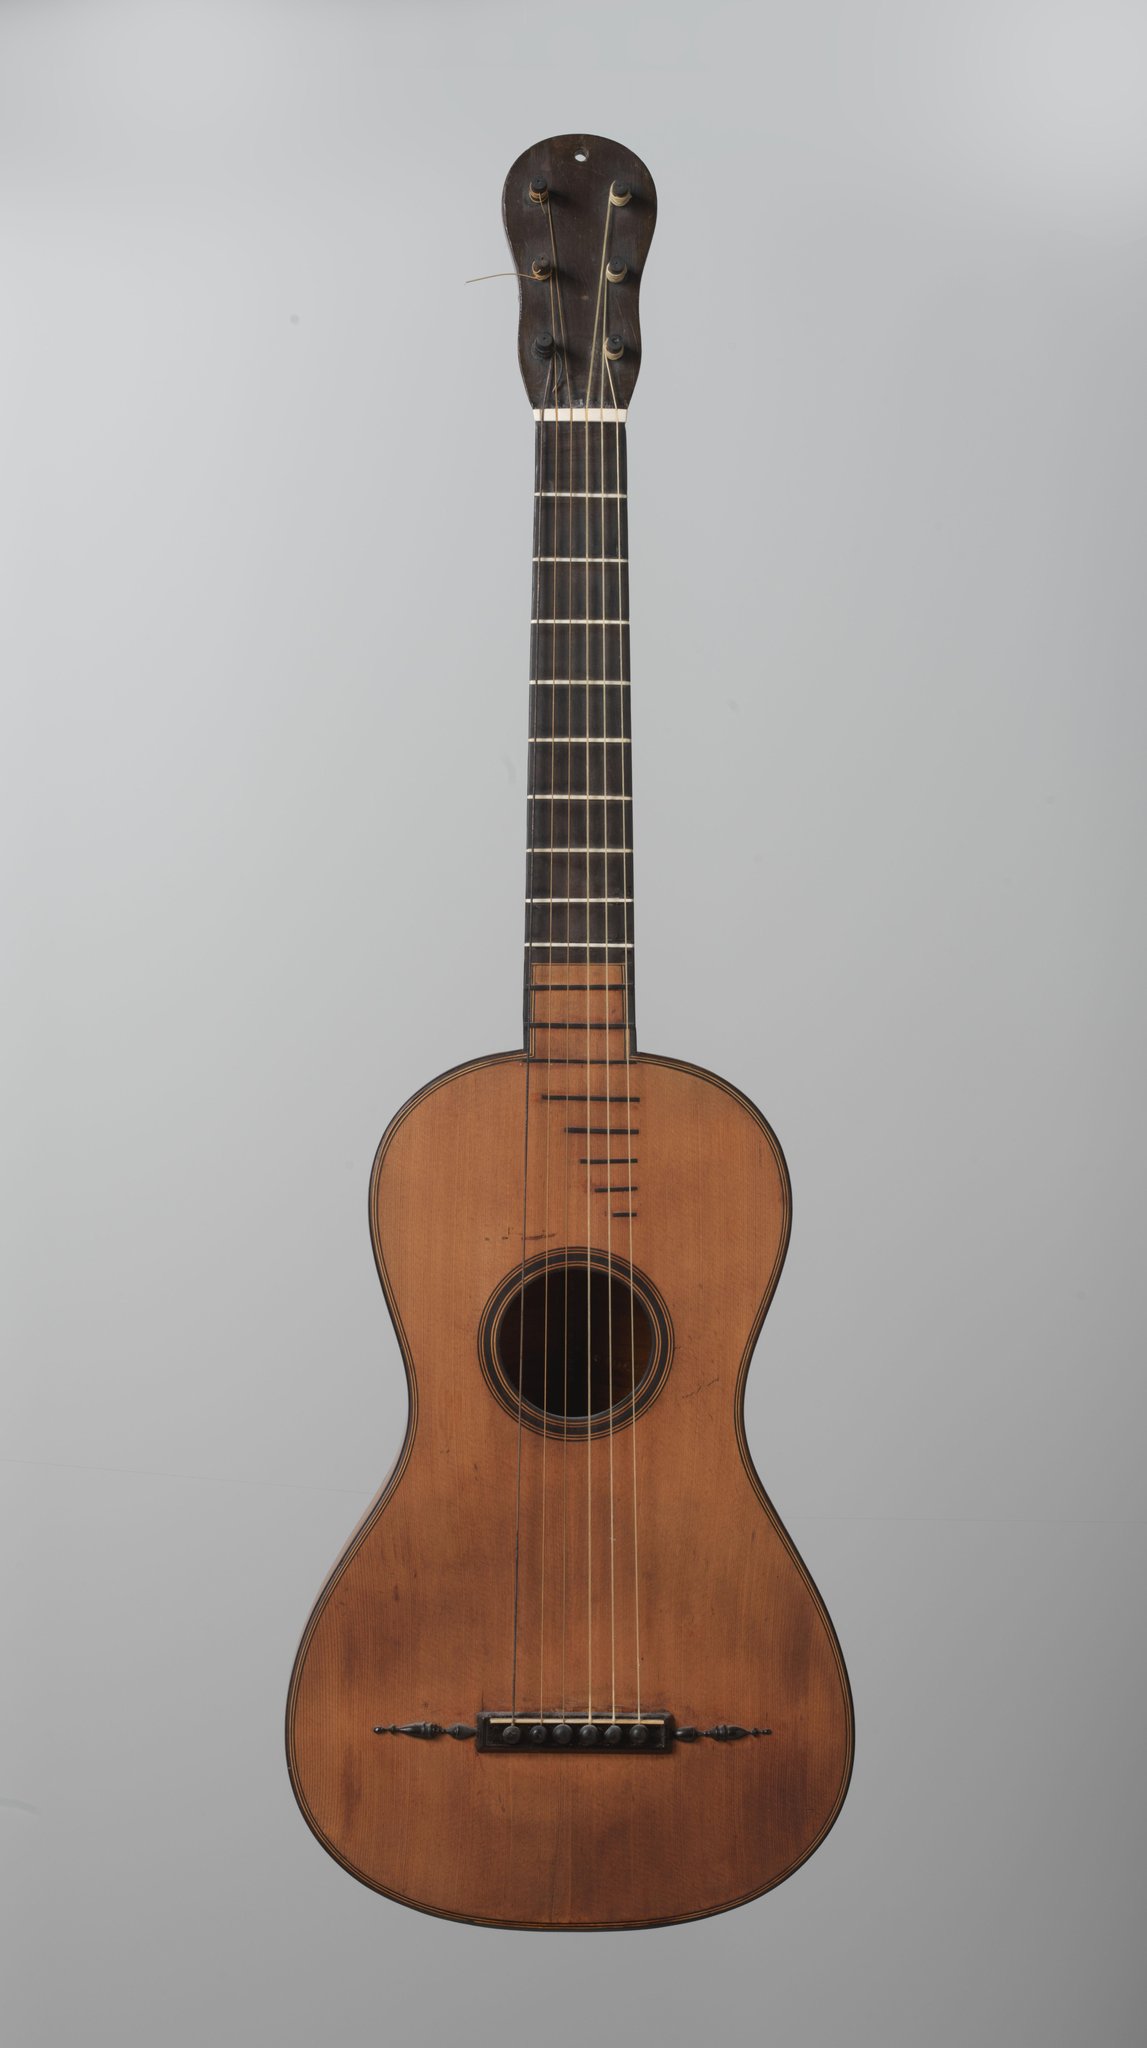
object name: stringed instrument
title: Guitar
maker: augustin claudot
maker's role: musical instrument maker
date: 1820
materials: ivory, wood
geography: paris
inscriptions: stamp: ‘AUGUSTIN. / CLAUDOT’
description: Six-string guitar with a two-piece front of fine grain spruce with ebonised bridge and side turned ornaments. The back (in two pieces) and ribs are figured maple. The centre of back and ribs striped with a line of ebonised wood. Ebony fingerboard with bone frets and five ebony frets on front. An inscription stamped on the back, below the sound hole, reads 'AUGUSTIN. / CLAUDOT'.